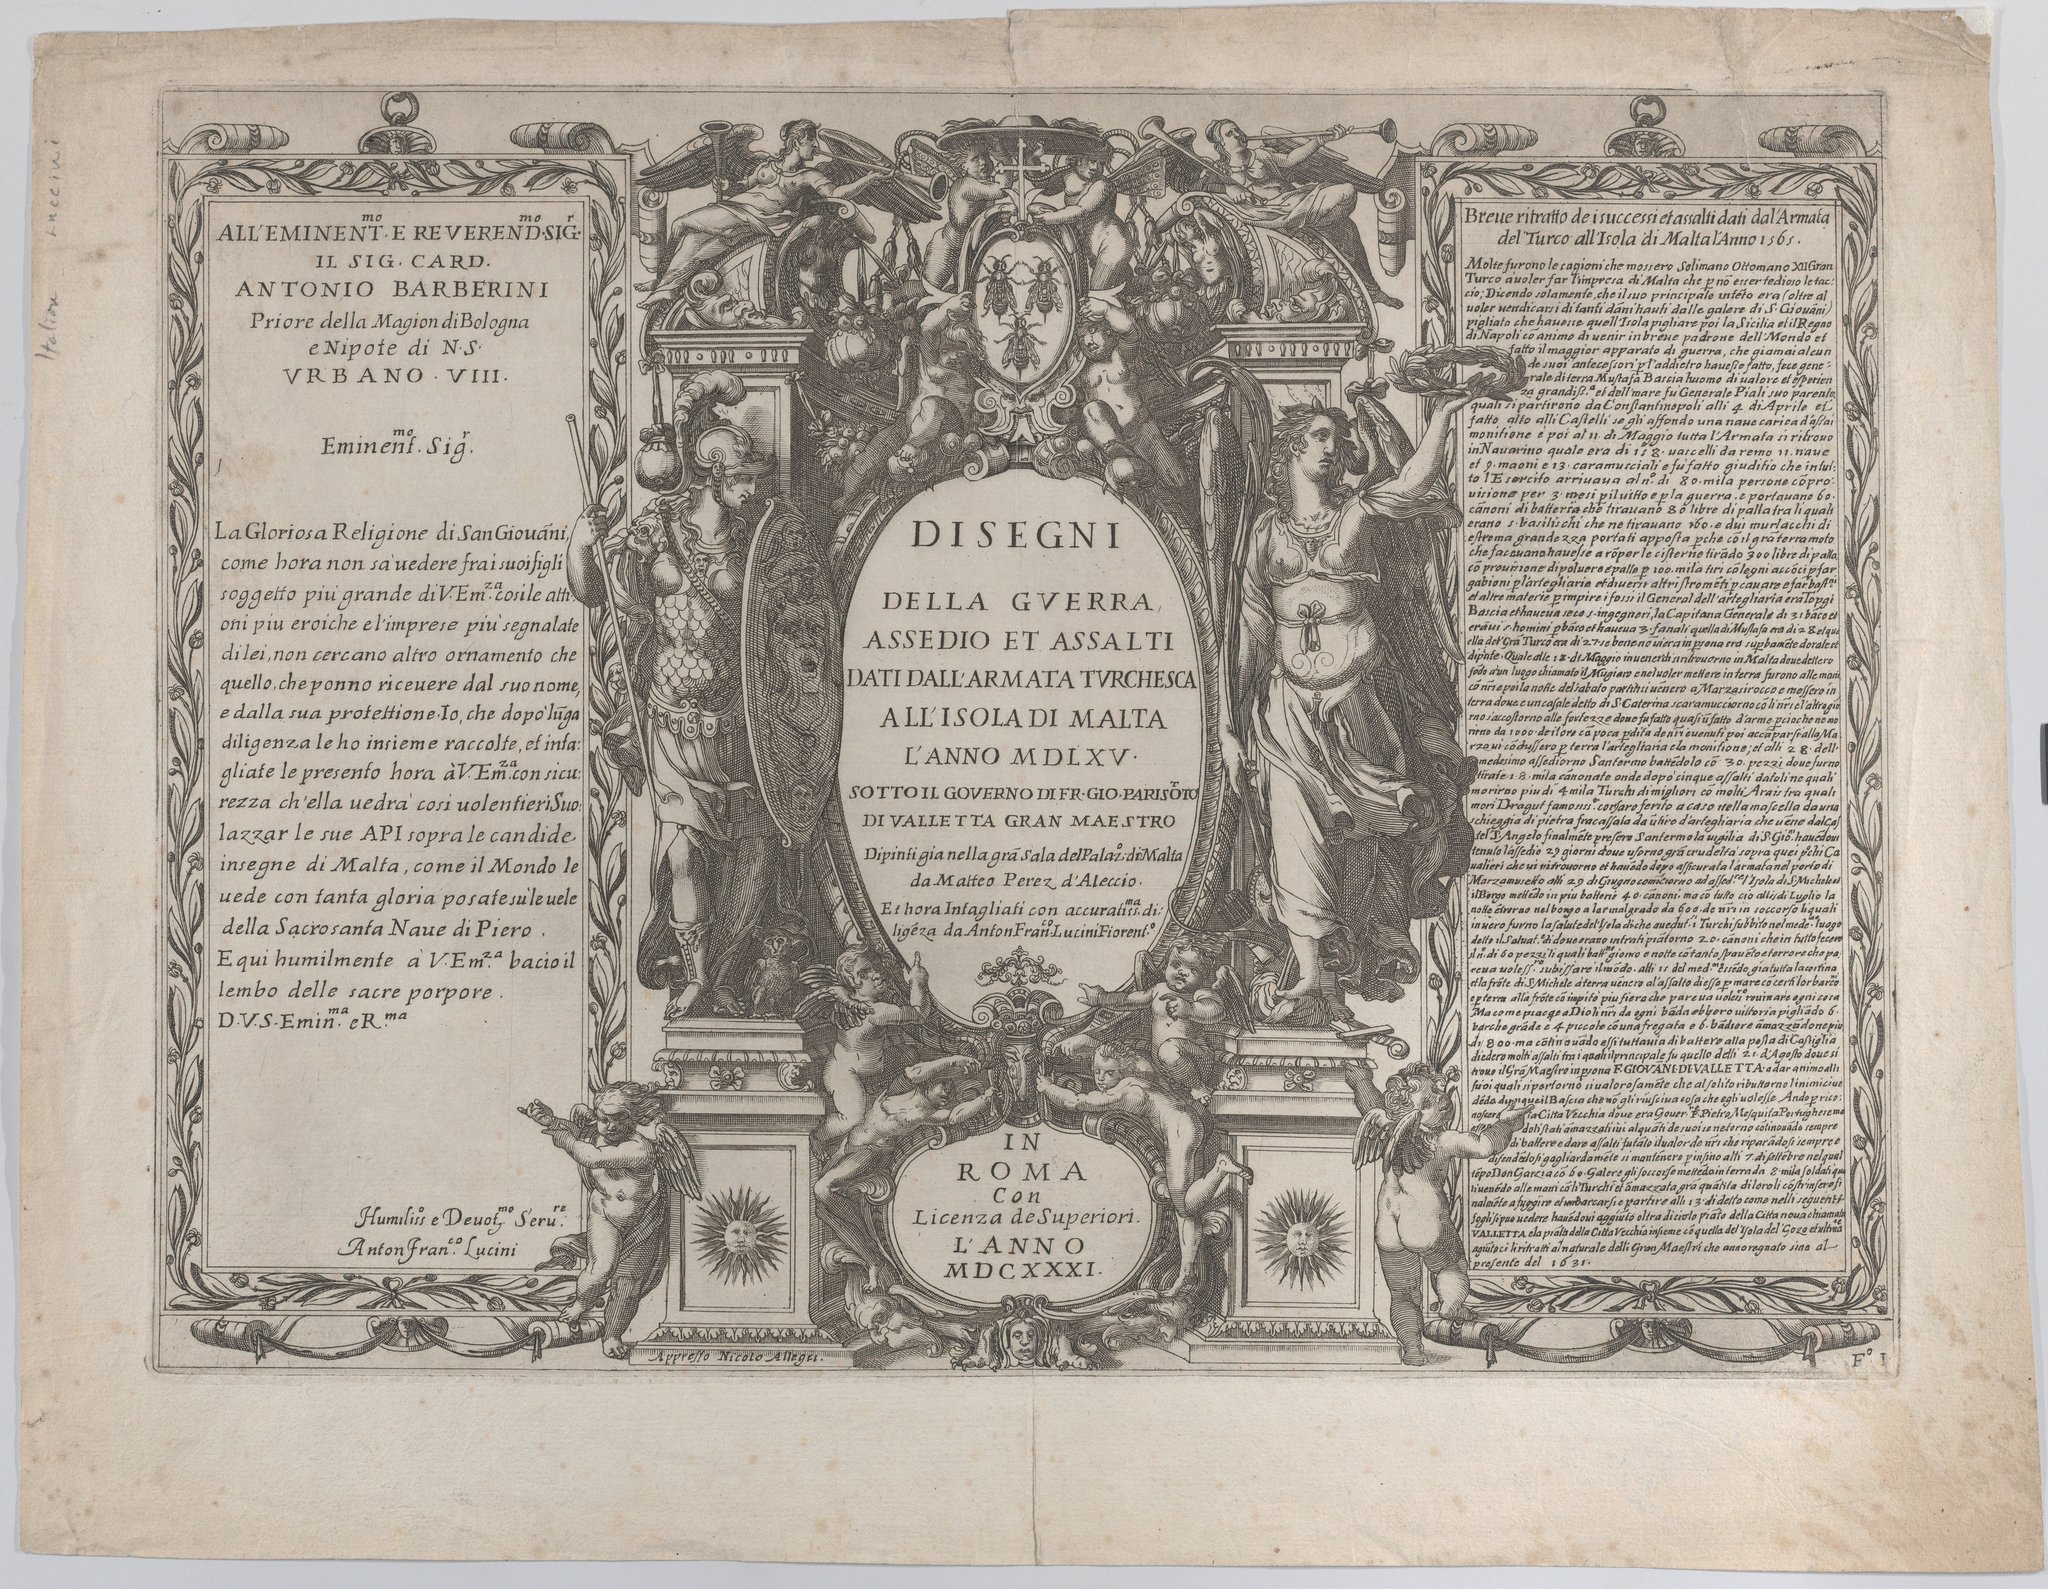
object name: print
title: Frontispiece for "Drawings of the war, siege, and assault of the Turkish army on the island of Malta" (Disegni della guerra, assedio et assalti dati dell'armata turchesca all'isola di Malta)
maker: antonio francesco luccini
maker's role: artist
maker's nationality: italian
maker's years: 1605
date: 1631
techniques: etching